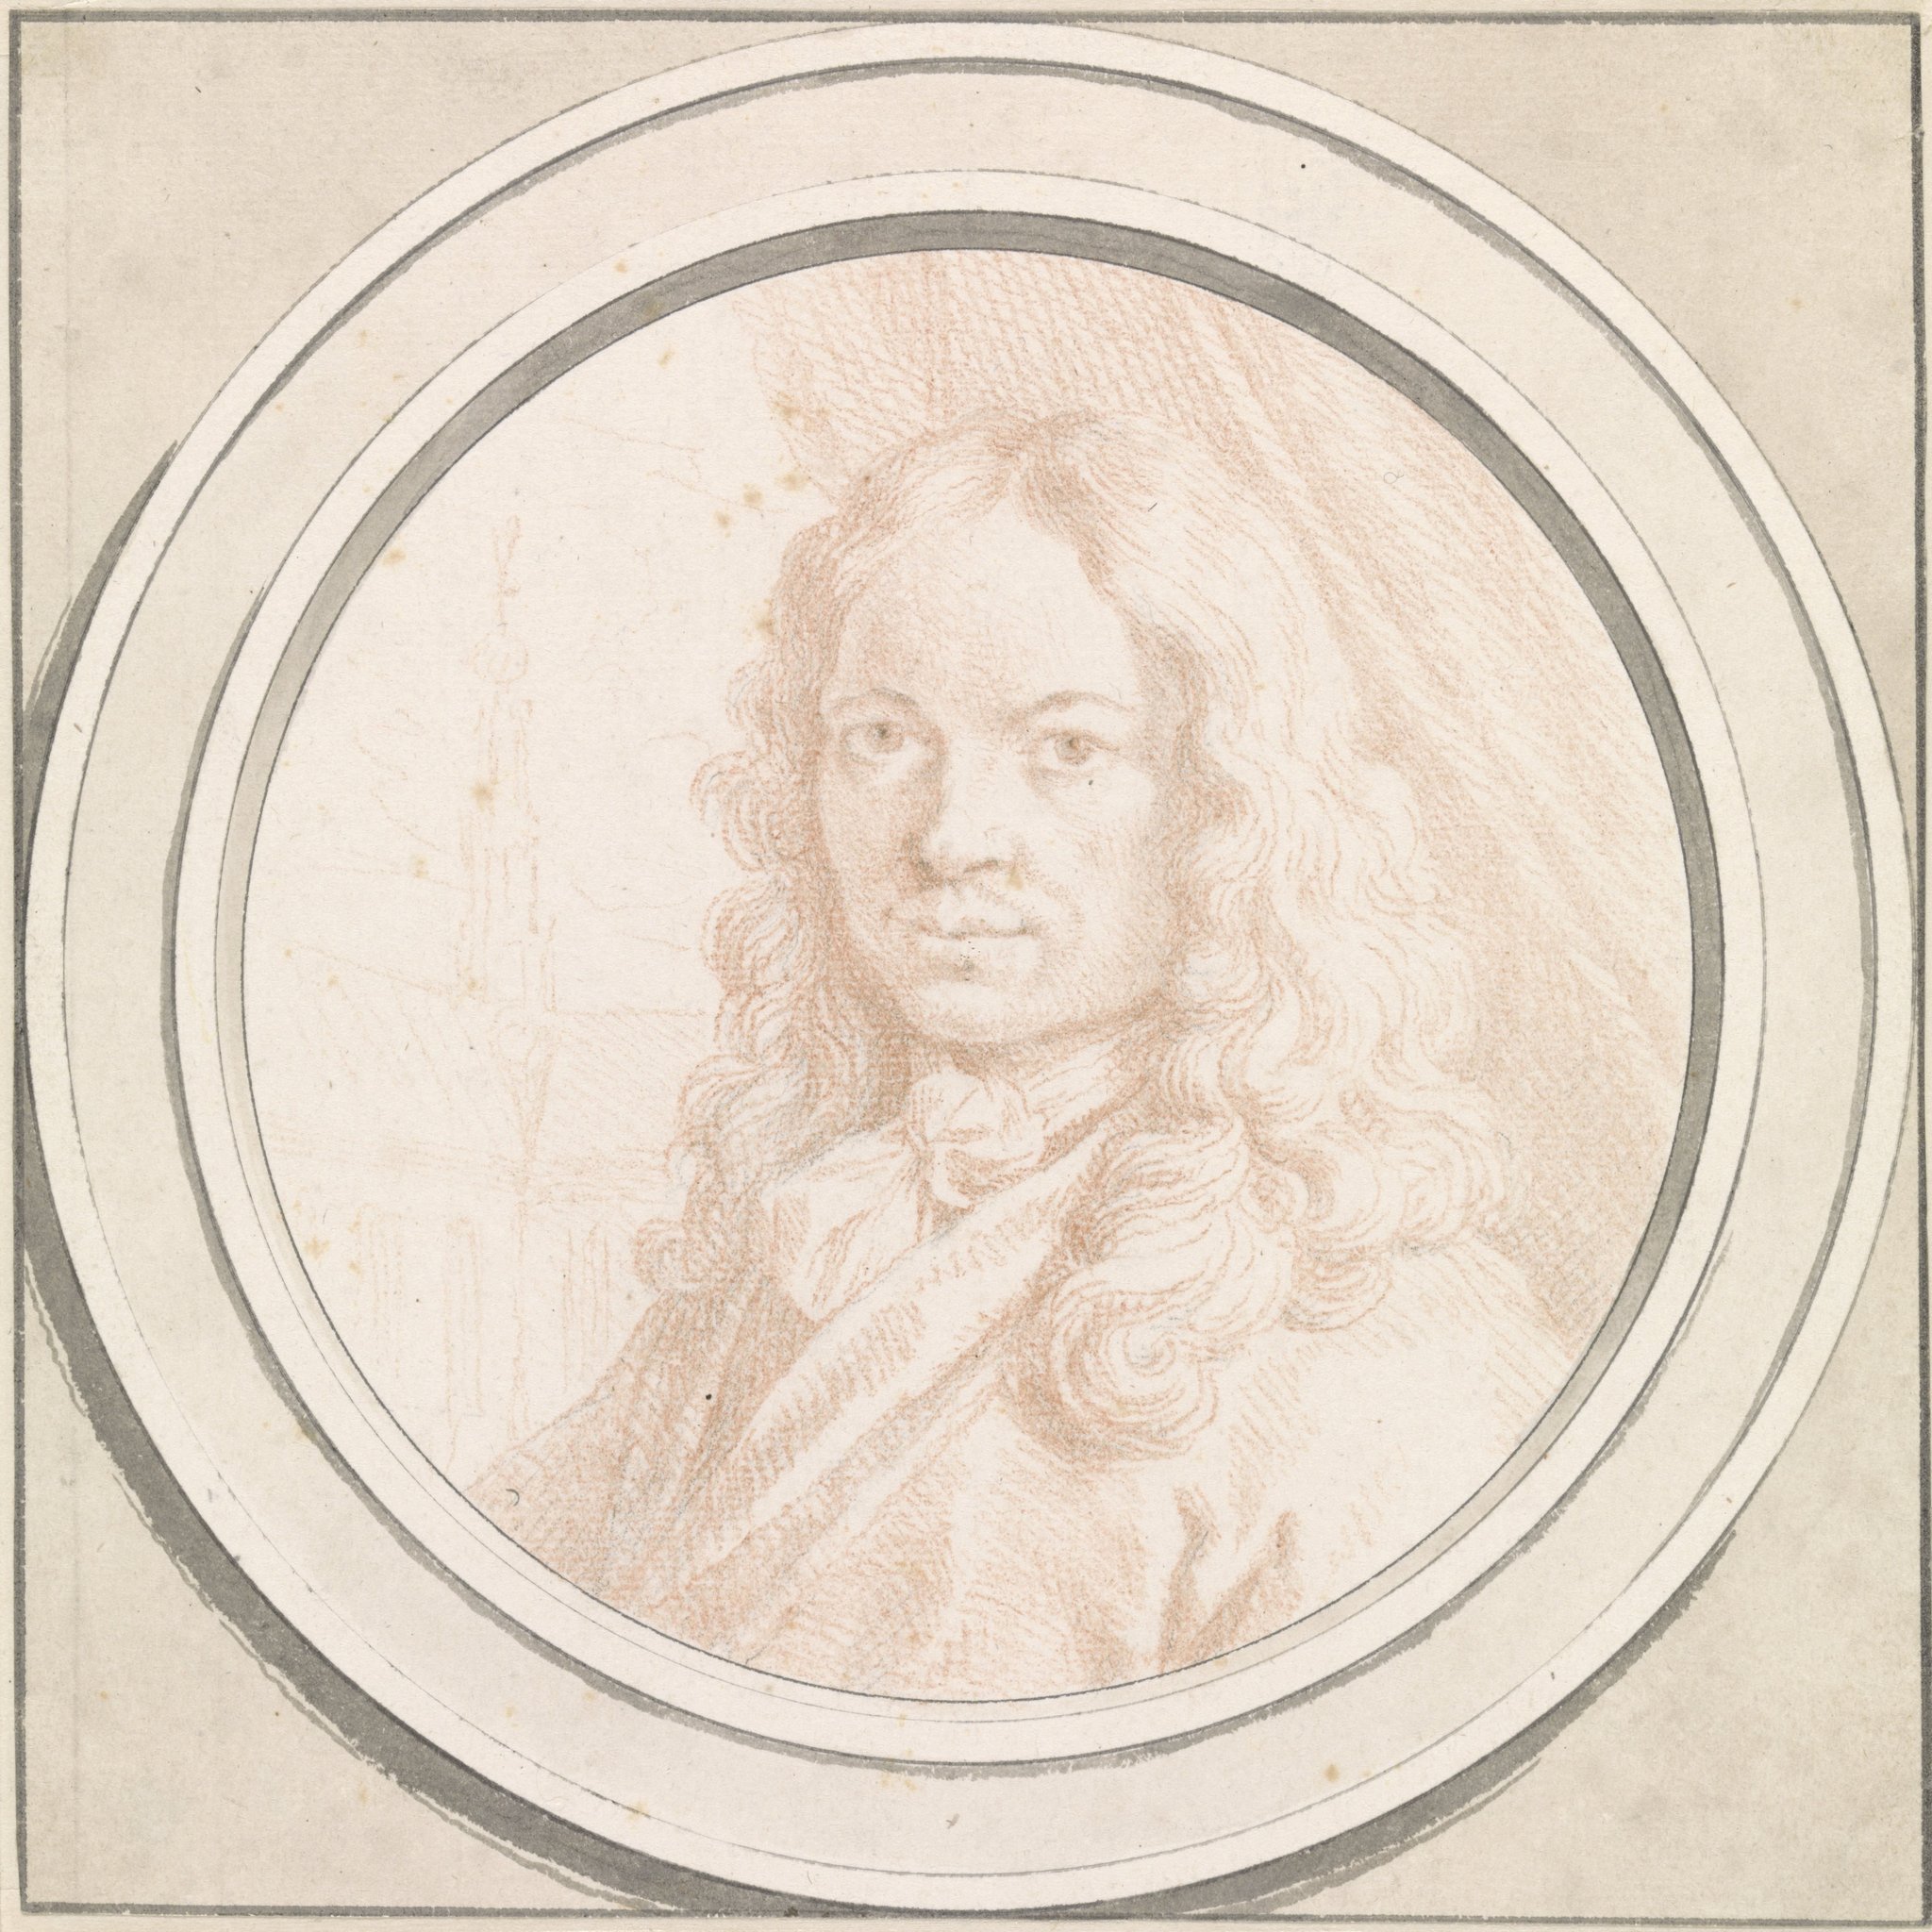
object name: drawing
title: Portret van Gerrit Adriaansz. Berckheyde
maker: frans decker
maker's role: draughtsman, painter, print maker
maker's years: 1684-1751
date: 1694-1751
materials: paper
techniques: printmaking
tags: haarlem, painter, draughtsman, gerrit berckheyde, historical persons, portrait, self-portrait of painter, portrait, self-portrait of artist, portrait, self-portrait of draughtsman